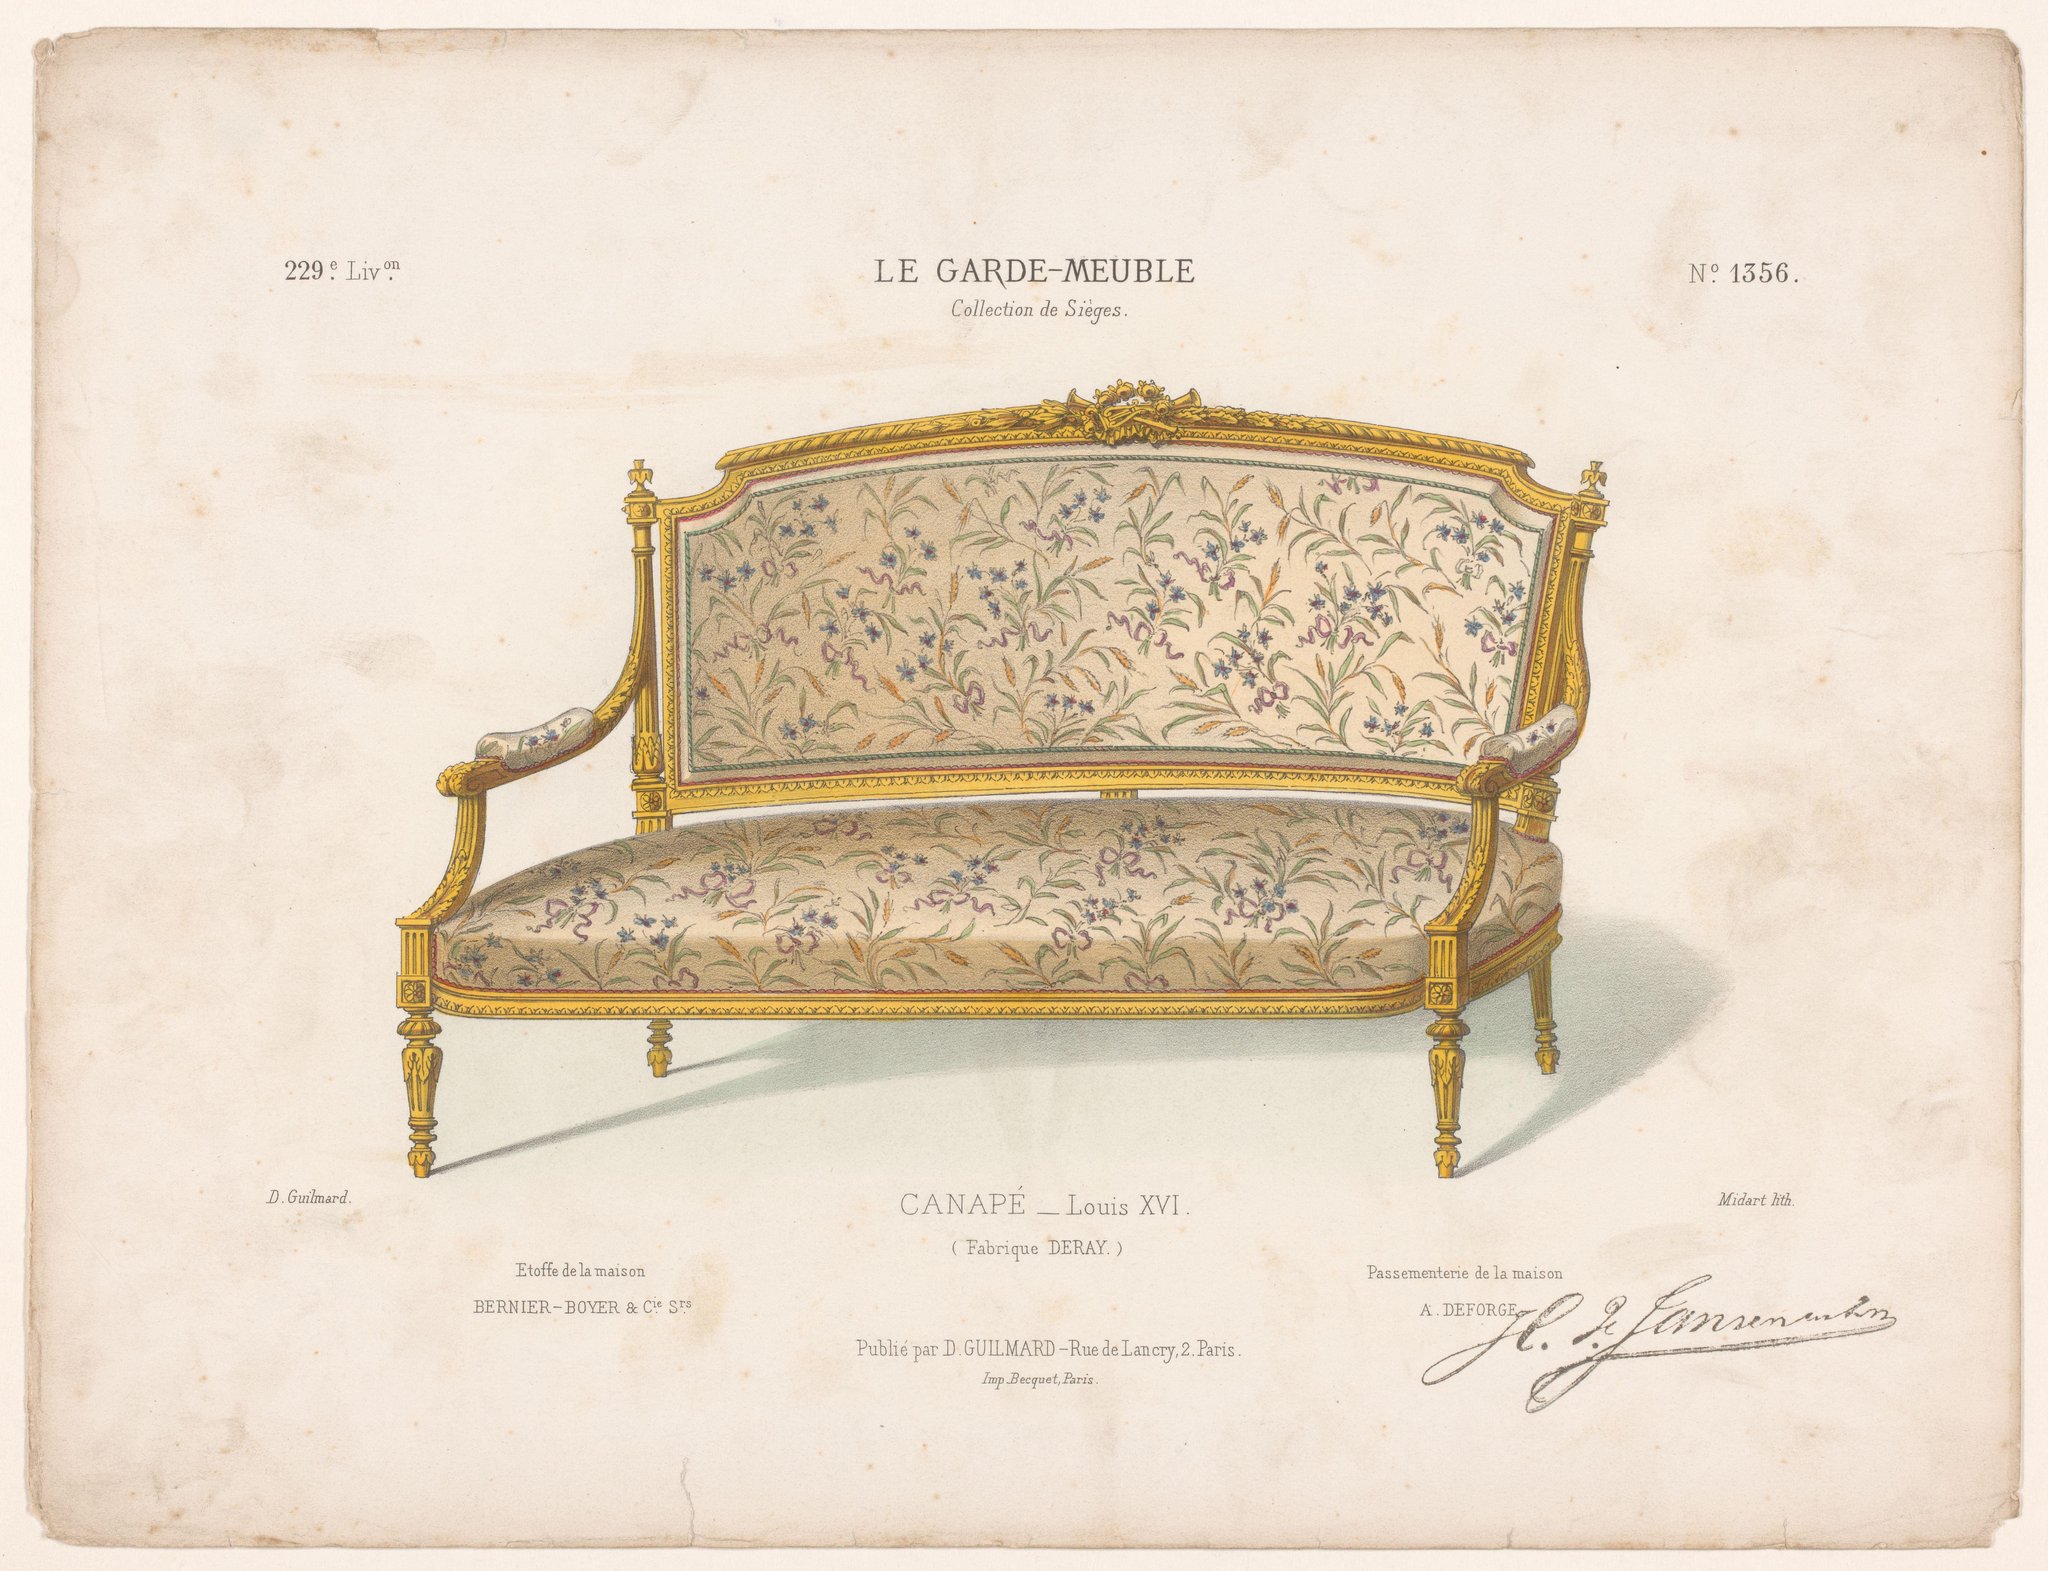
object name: print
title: Canapé Louis XVI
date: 1839-1885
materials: paper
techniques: hand coloring, lithograph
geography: paris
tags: seating furniture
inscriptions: stamp: ‘H.F. Jansen en Zn’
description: Ieder Livraison in de serie Le Garde-Meuble bevat negen platen: drie 'sièges' (zitmeubels), drie 'meubles' (diverse meubels zoals tafels en kasten) en drie 'tentures' (gordijnen en draperieën).